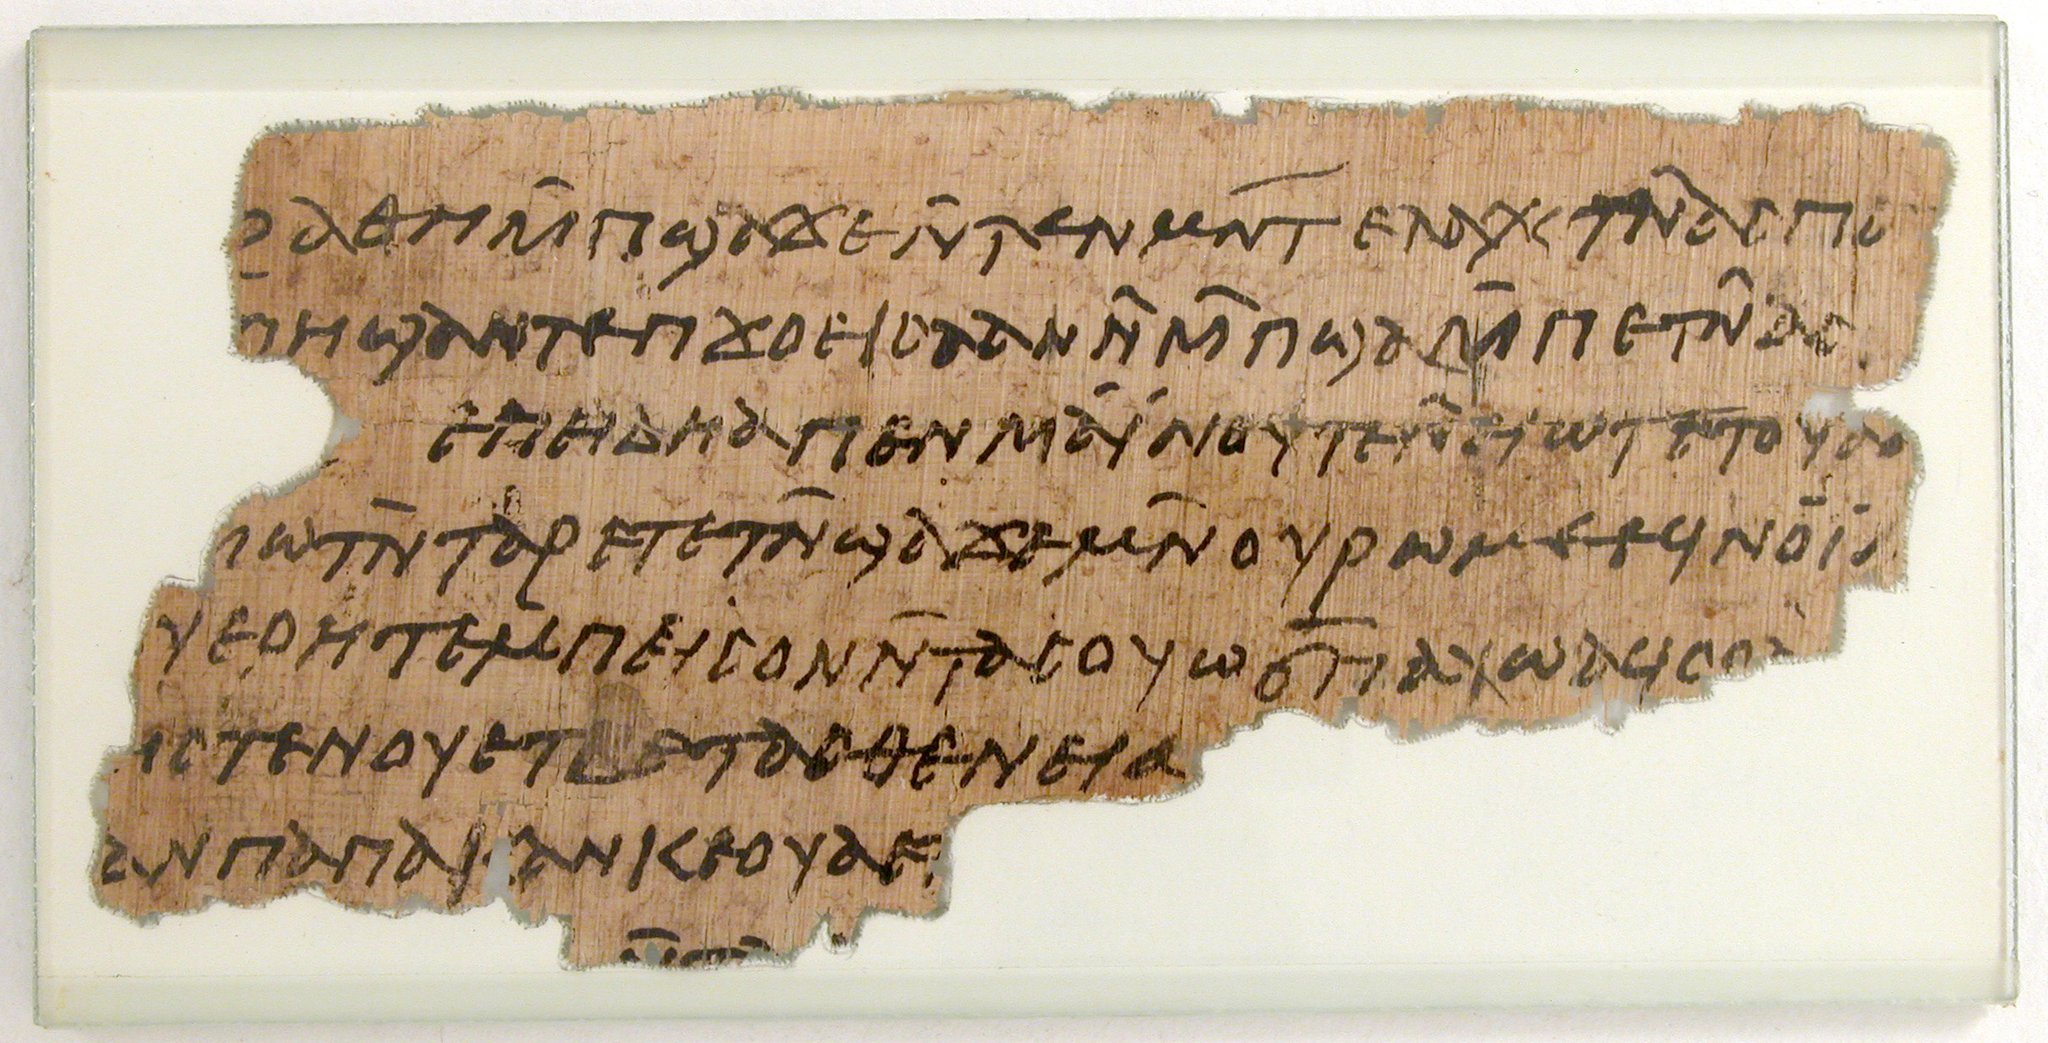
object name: fragment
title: Papyrus Fragment of a Letter from John to Epiphanius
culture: coptic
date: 601-700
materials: ink, papyrus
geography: egypt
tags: coptic,documents